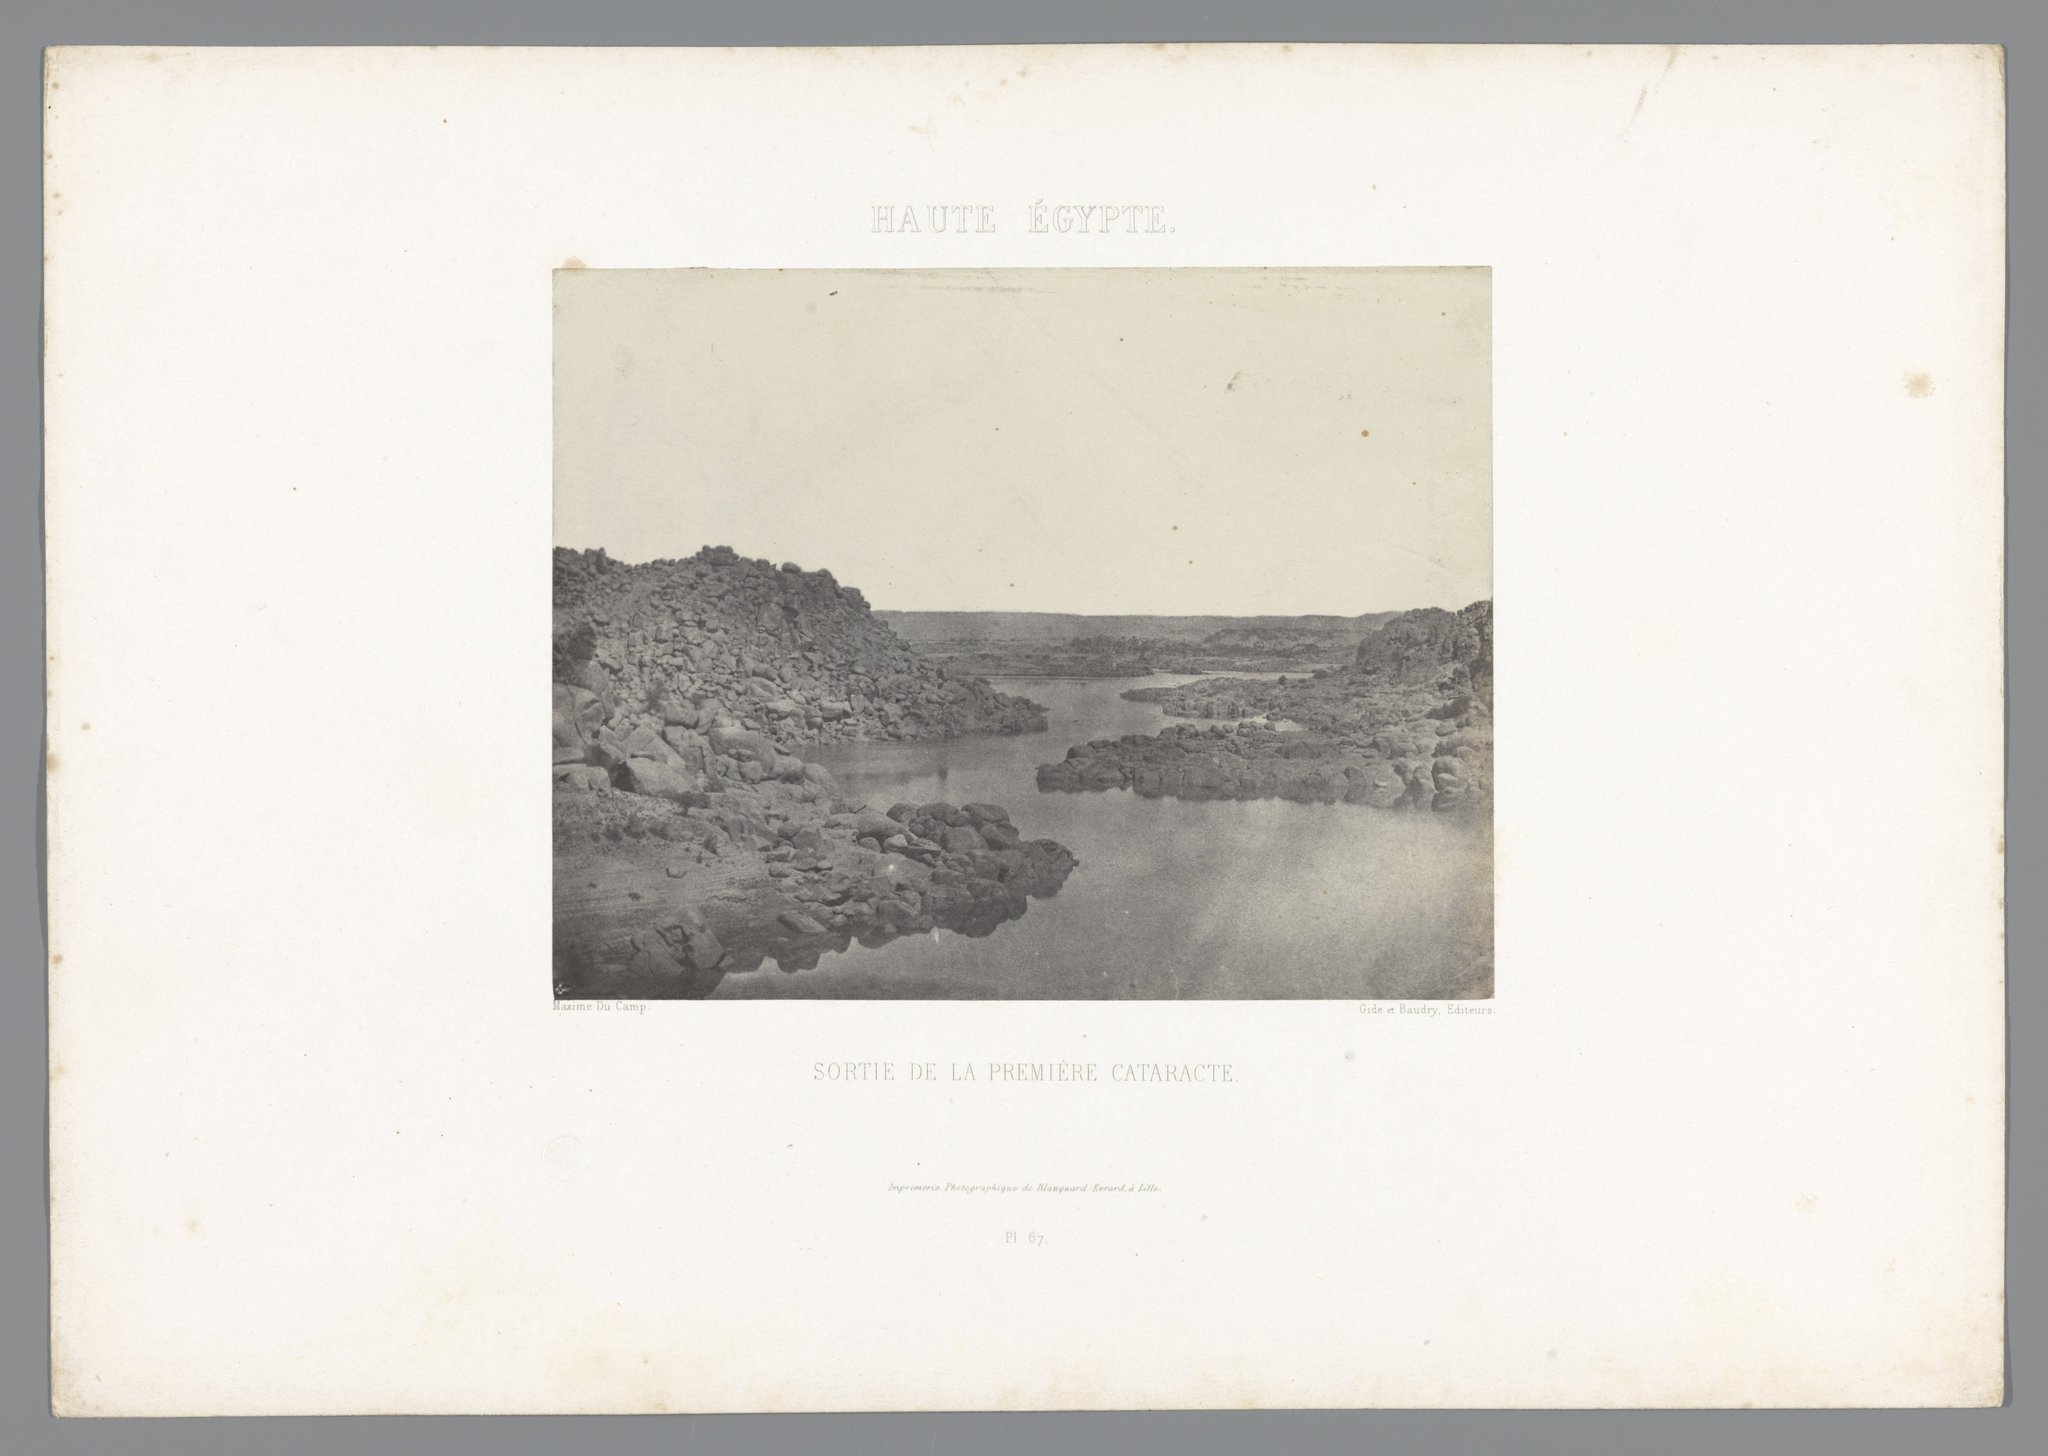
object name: photograph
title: Eerste cataract bij Aswan, Egypte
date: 1849-1851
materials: cardboard, paper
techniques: salted paper print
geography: aswan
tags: river, waterfall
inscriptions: caption: ‘Maxime Du Camp./ Gide et Baudry, Editeurs./ SORTIE DE LA PREMIÈRE CATARACTE./ Imprimerie Photographique de Blanquard-Evrard, à Lille./ Pl. 67.’, check stamp: ‘MACGILL/ 7/ HANOVER/ ST./ EDINR.’